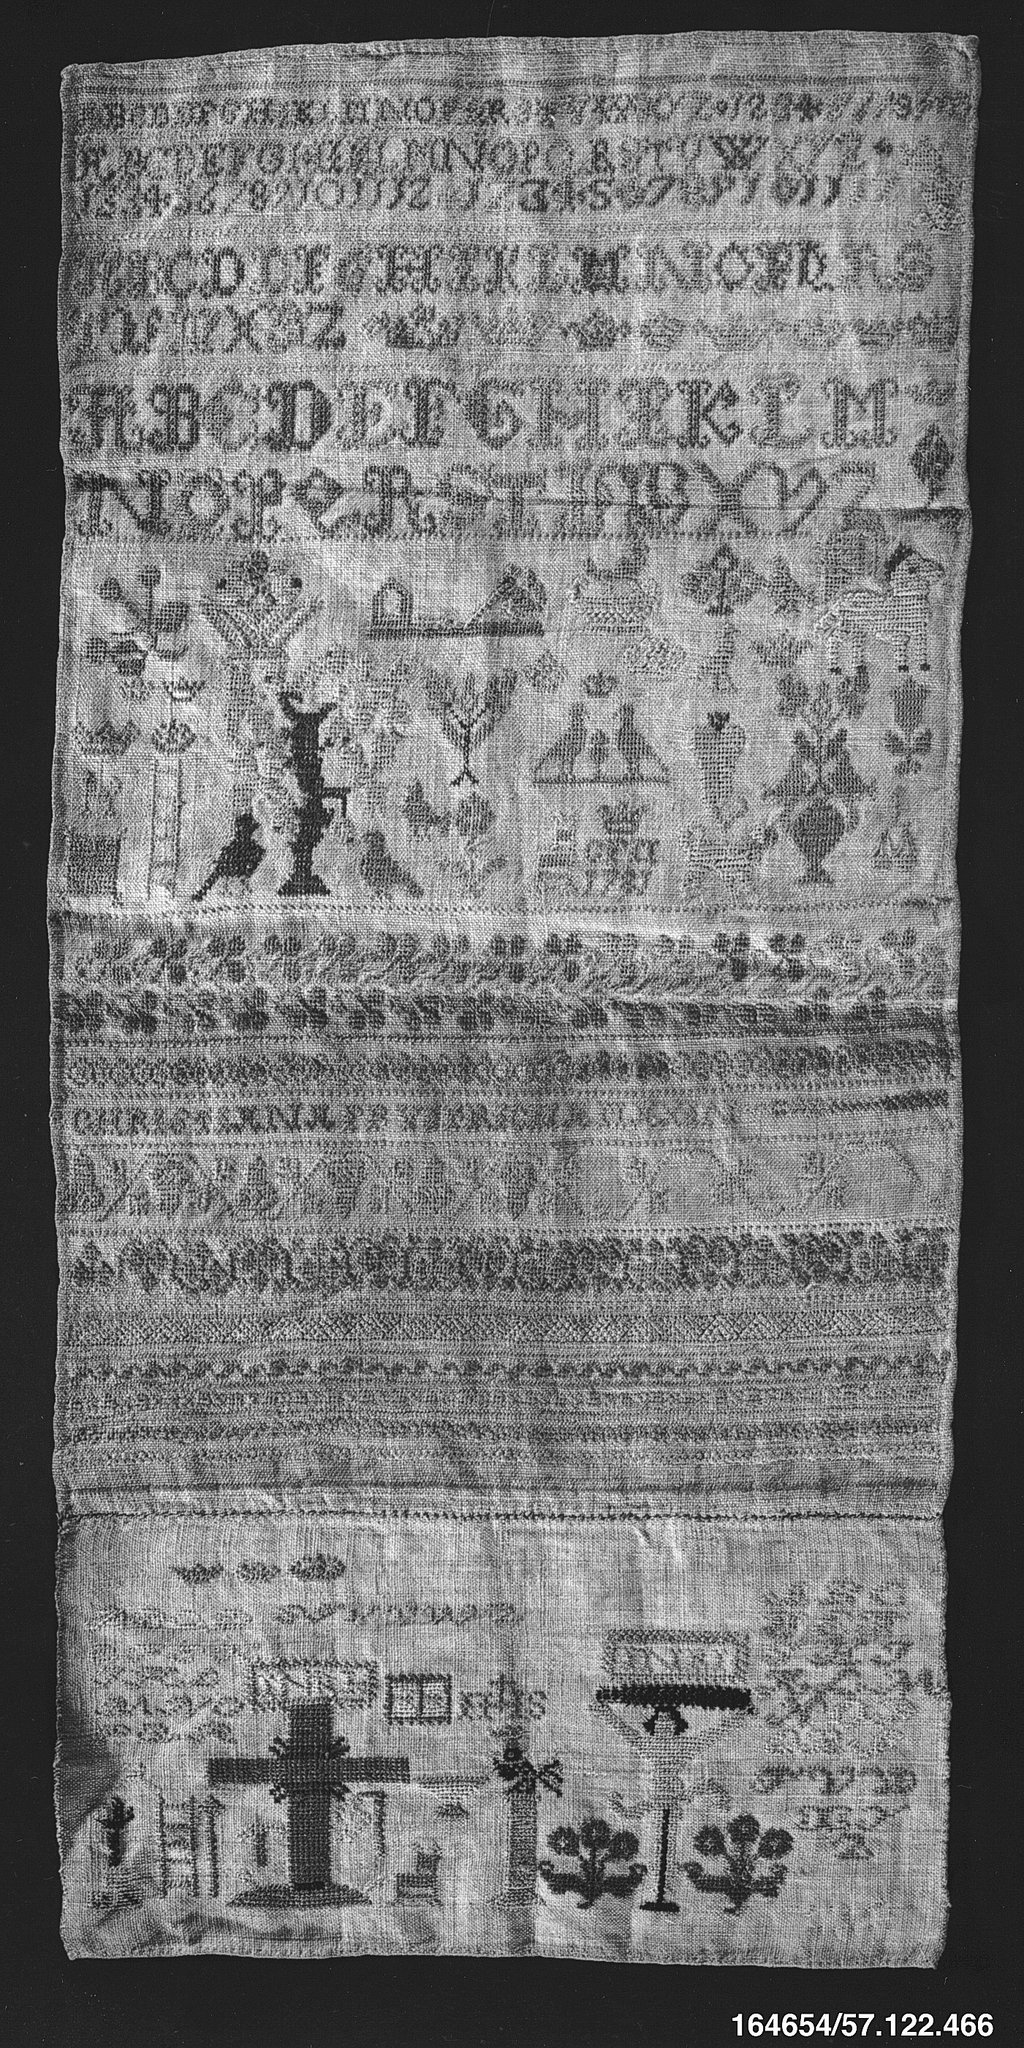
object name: sampler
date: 1781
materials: linen, silk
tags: birds,cross